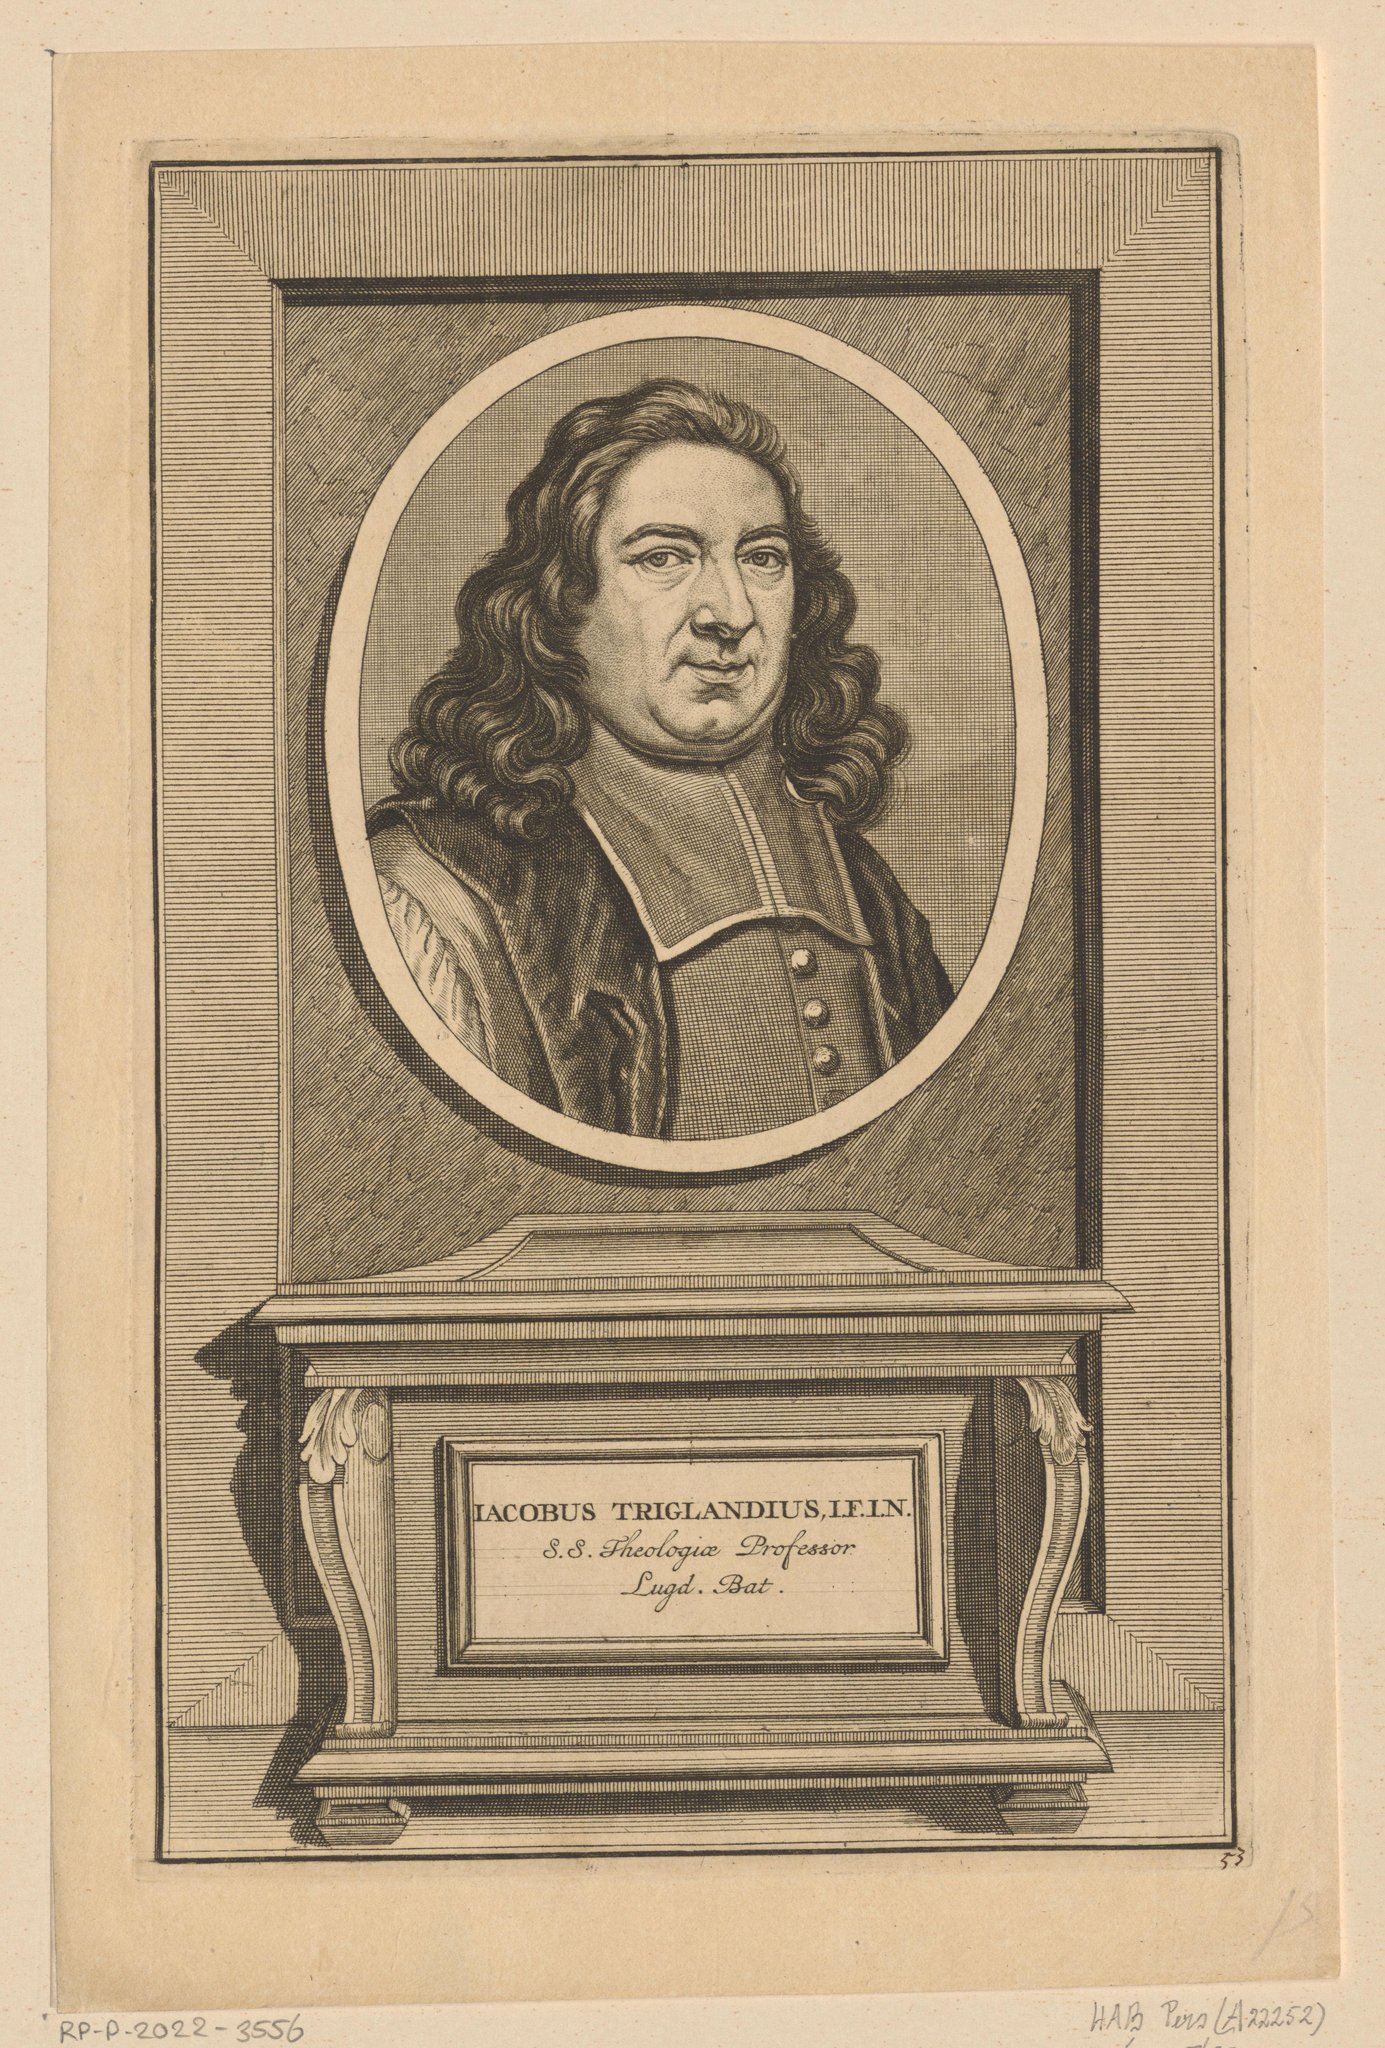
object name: print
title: Fundatoris, curatorum et professorum celeberrimorum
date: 1716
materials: paper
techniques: engraving, etching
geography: leiden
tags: haarlem, leiden, theologian, scholar, philosopher, historical persons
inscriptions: number: ‘53’